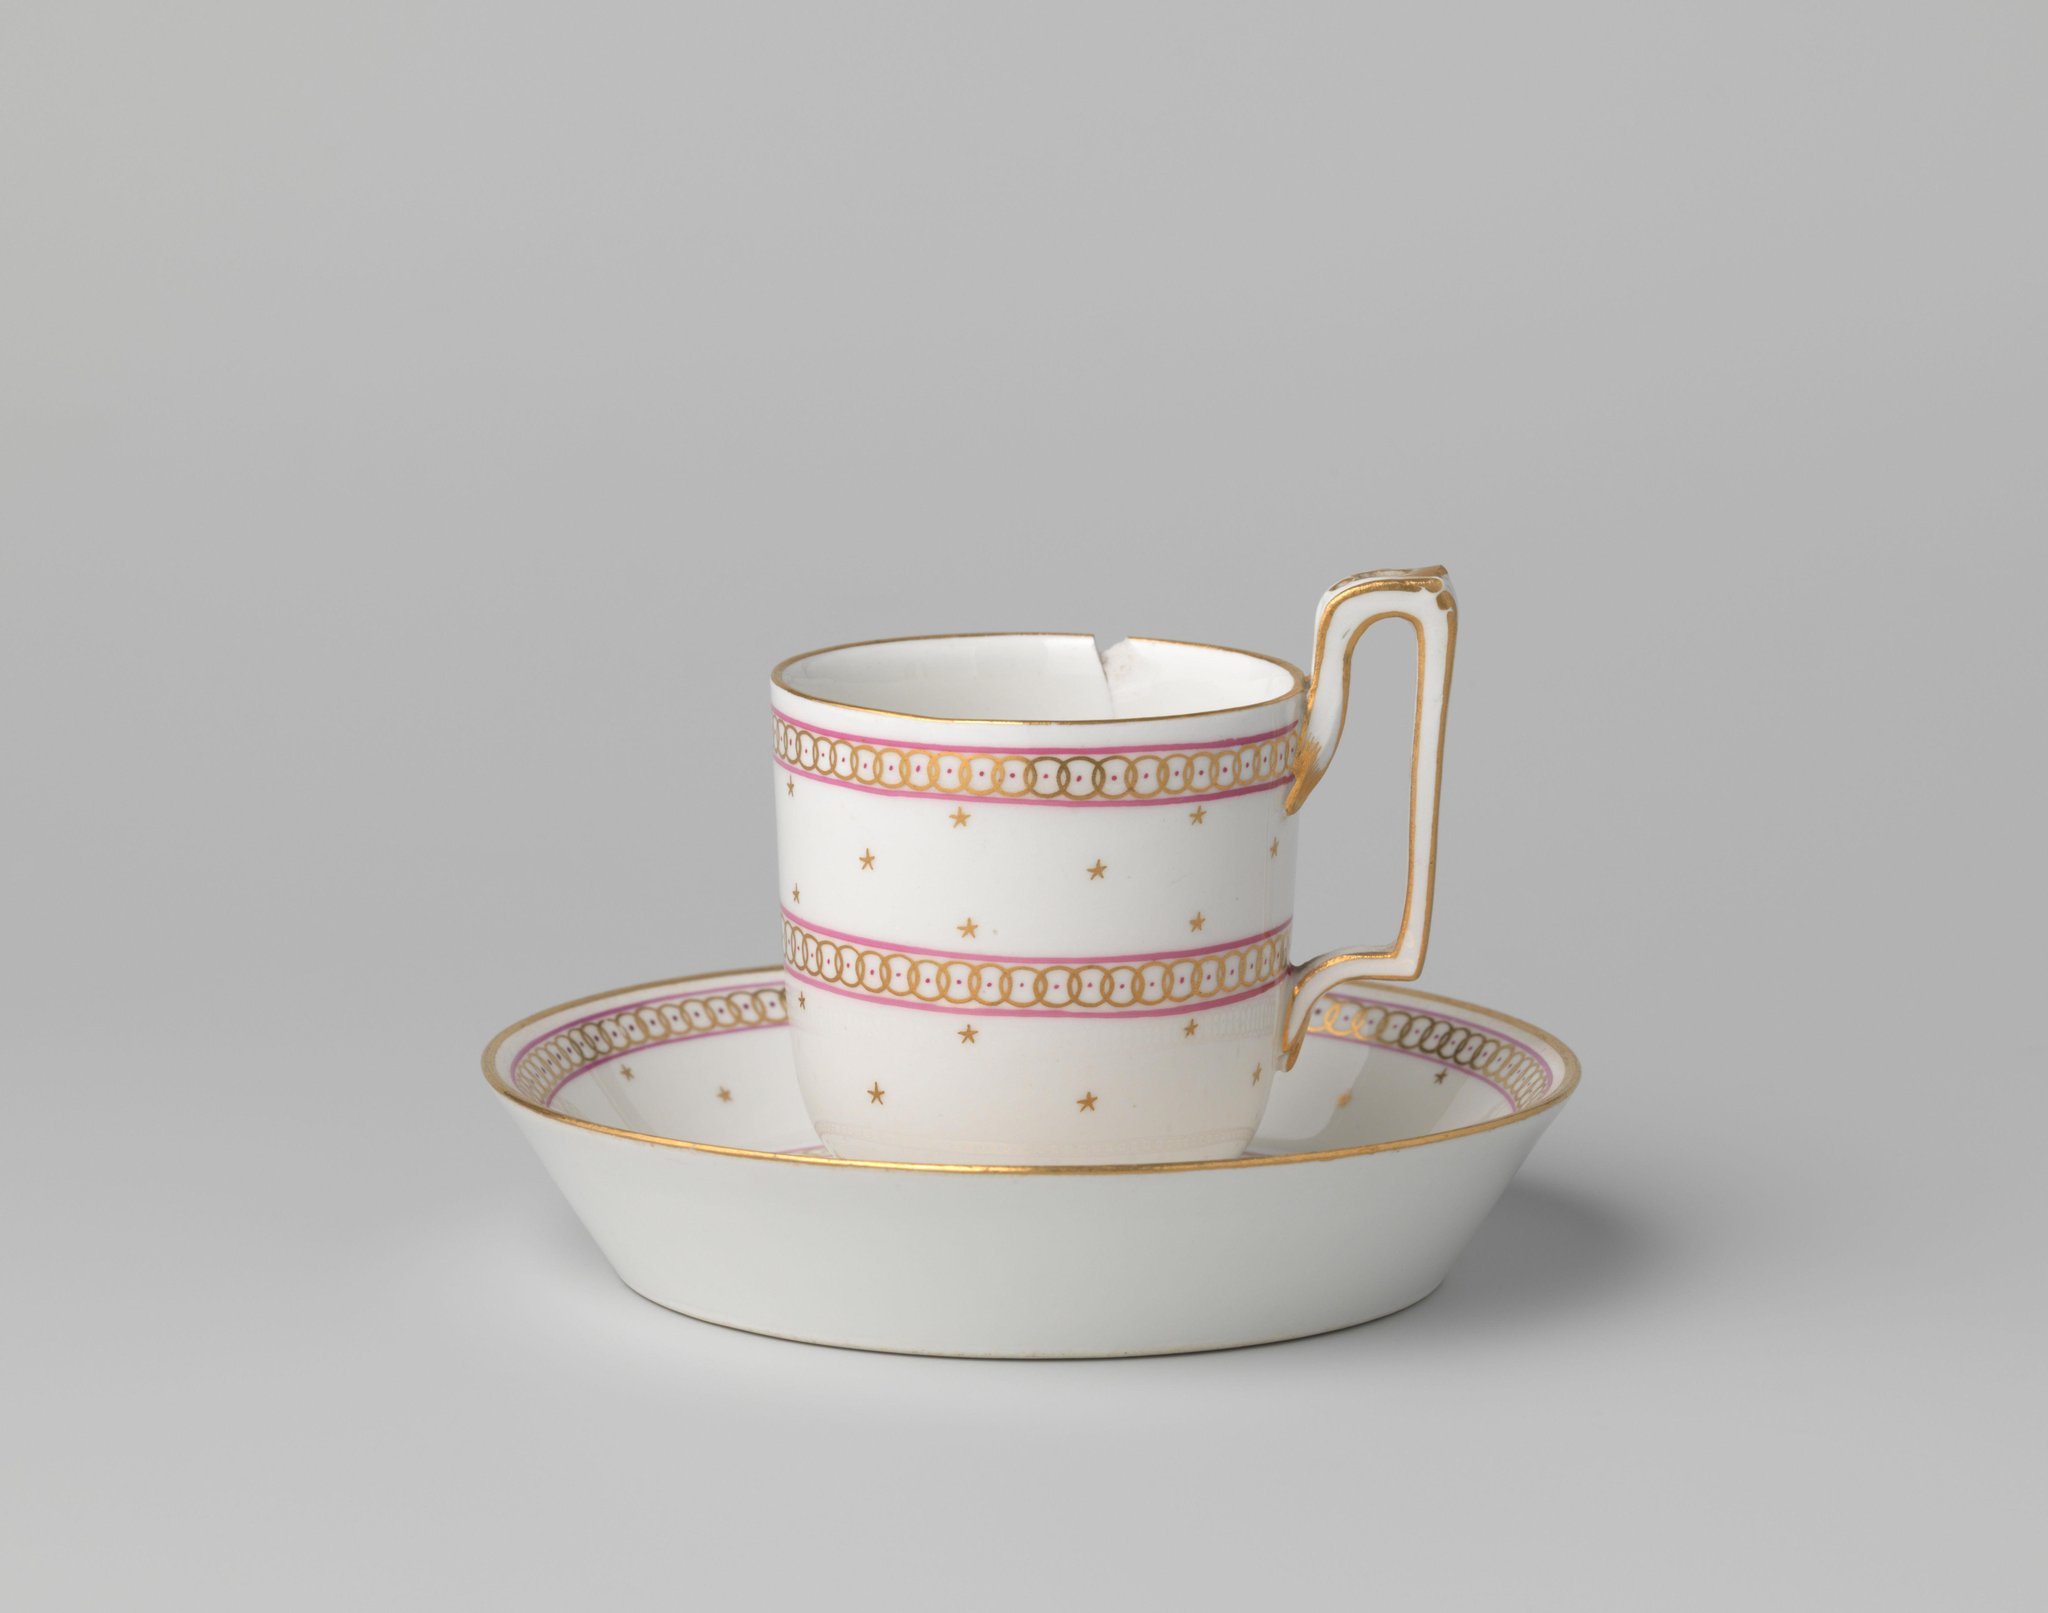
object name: cup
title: Cup with stars and ornamental borders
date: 1791-1801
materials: glaze, gold, paint, porcelain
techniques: firing, forming, gilding, turning, vitrification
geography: vienna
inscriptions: mark: ‘schild/ 110/ 33/ 91’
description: Kop van porselein met hoekig oor, beschilderd op het glazuur in roze en goud. De buitenwand is versierd met sterren en twee decoratieve banden van aaneengeschakelde cirkels met in elk een stip. Gemerkt met het schild, de nummers 110, 33 en jaarnummer 91. Barst in de wand.